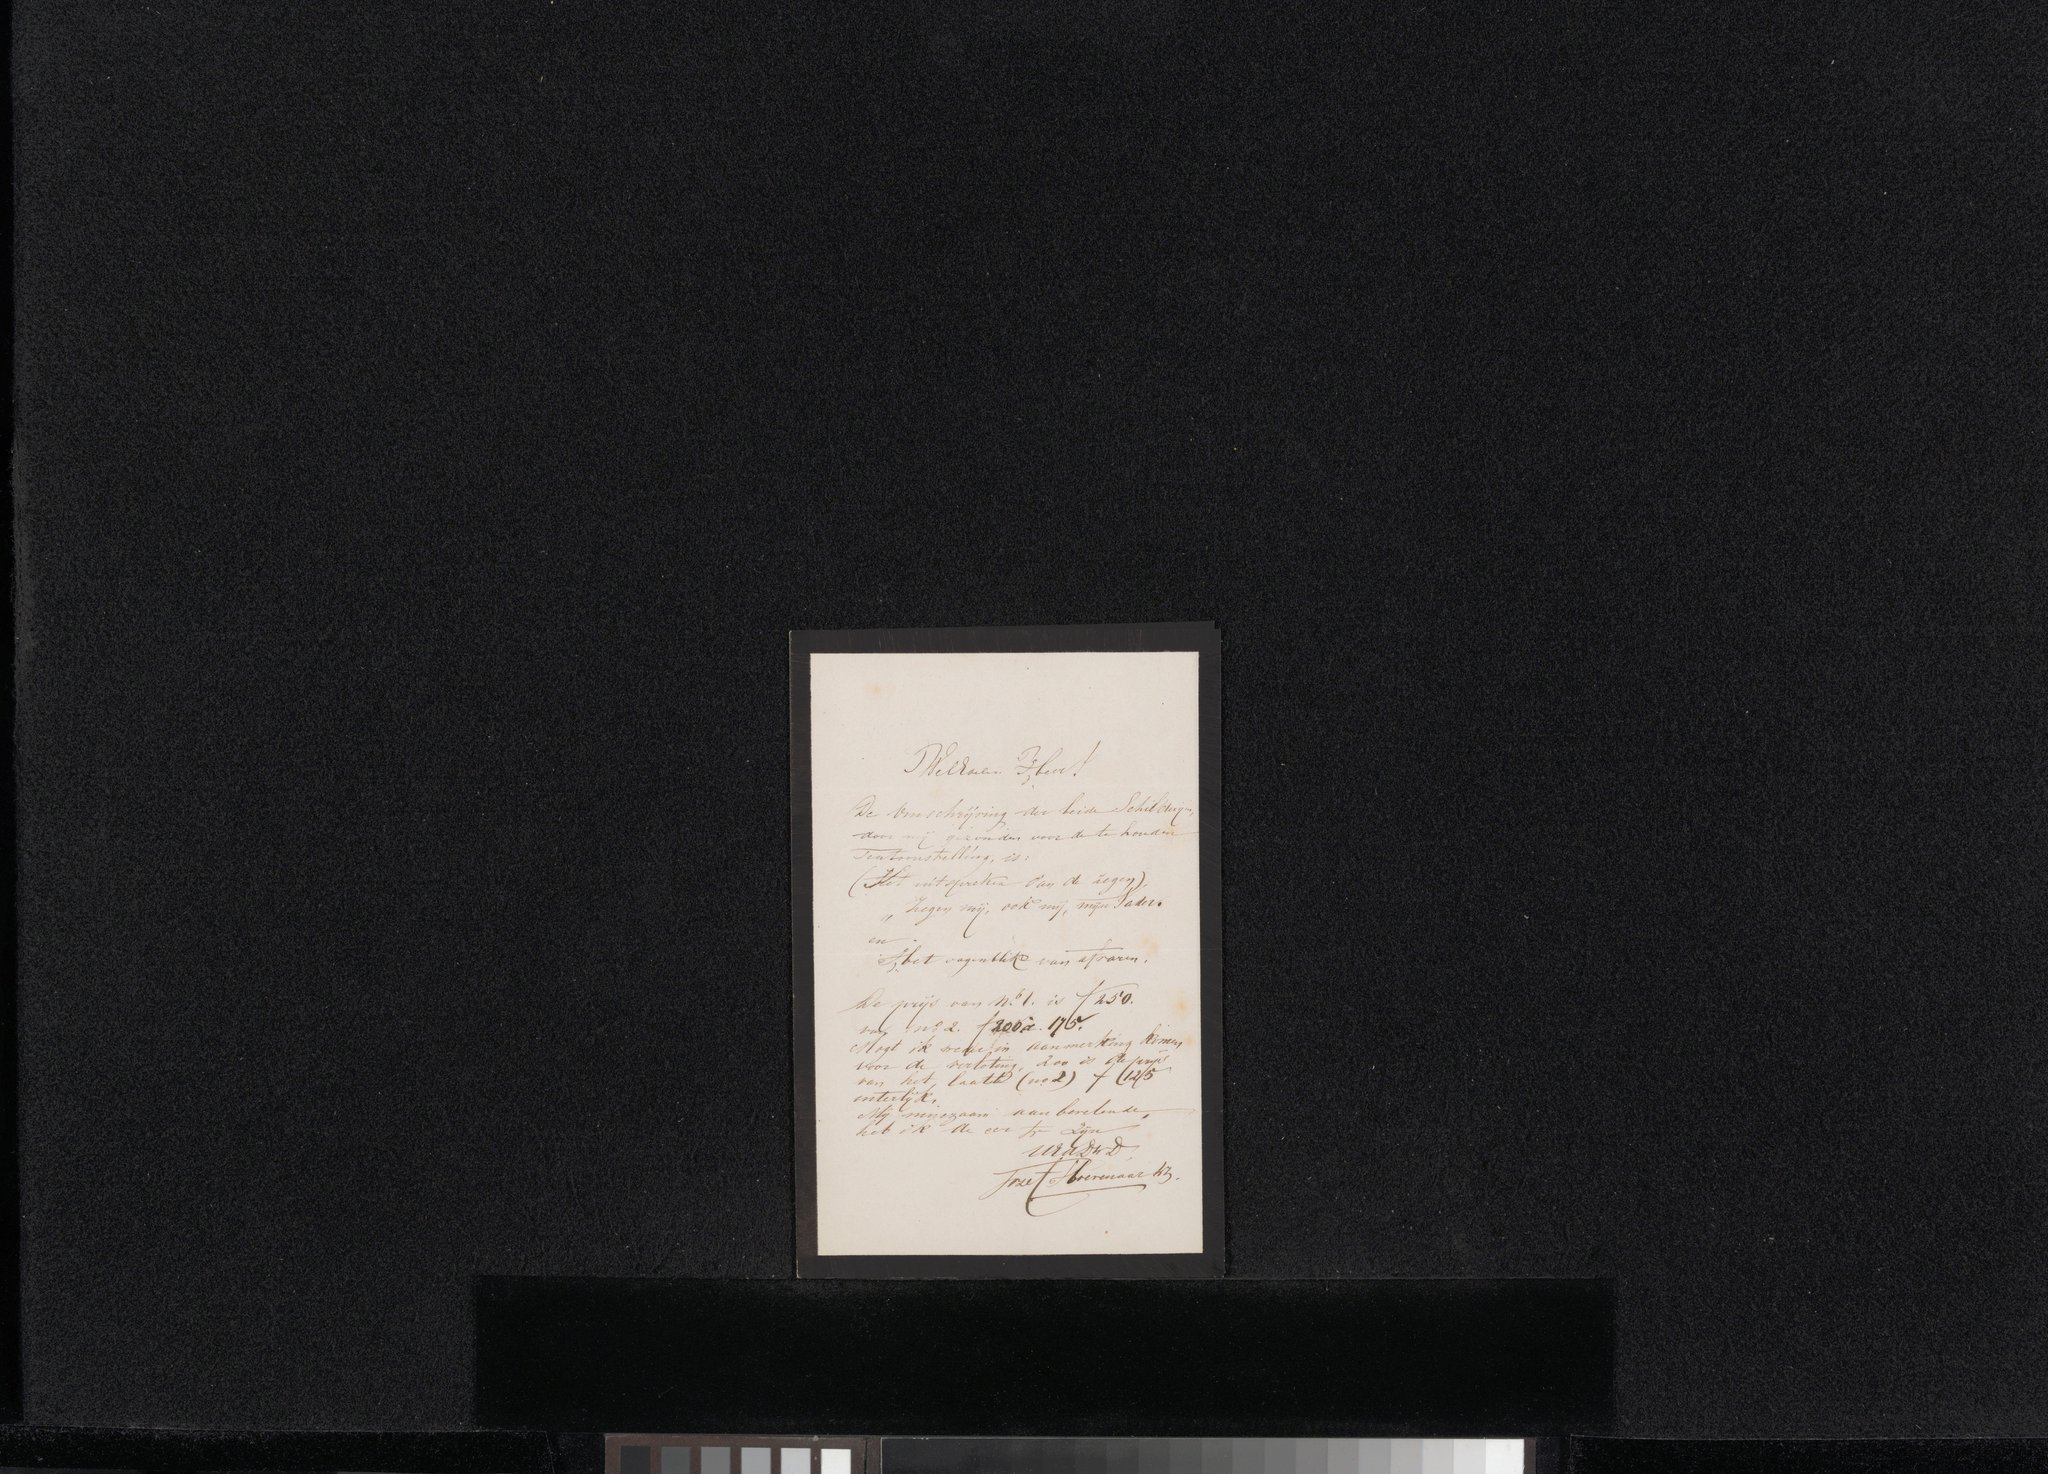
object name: letter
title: Brief aan anoniem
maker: jozef hoevenaar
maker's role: draughtsman, print maker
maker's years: 1840-1926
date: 1850-1926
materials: ink, paper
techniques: pen, writing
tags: painting (including book-illumination, miniature-painting), exhibition ~ art, money